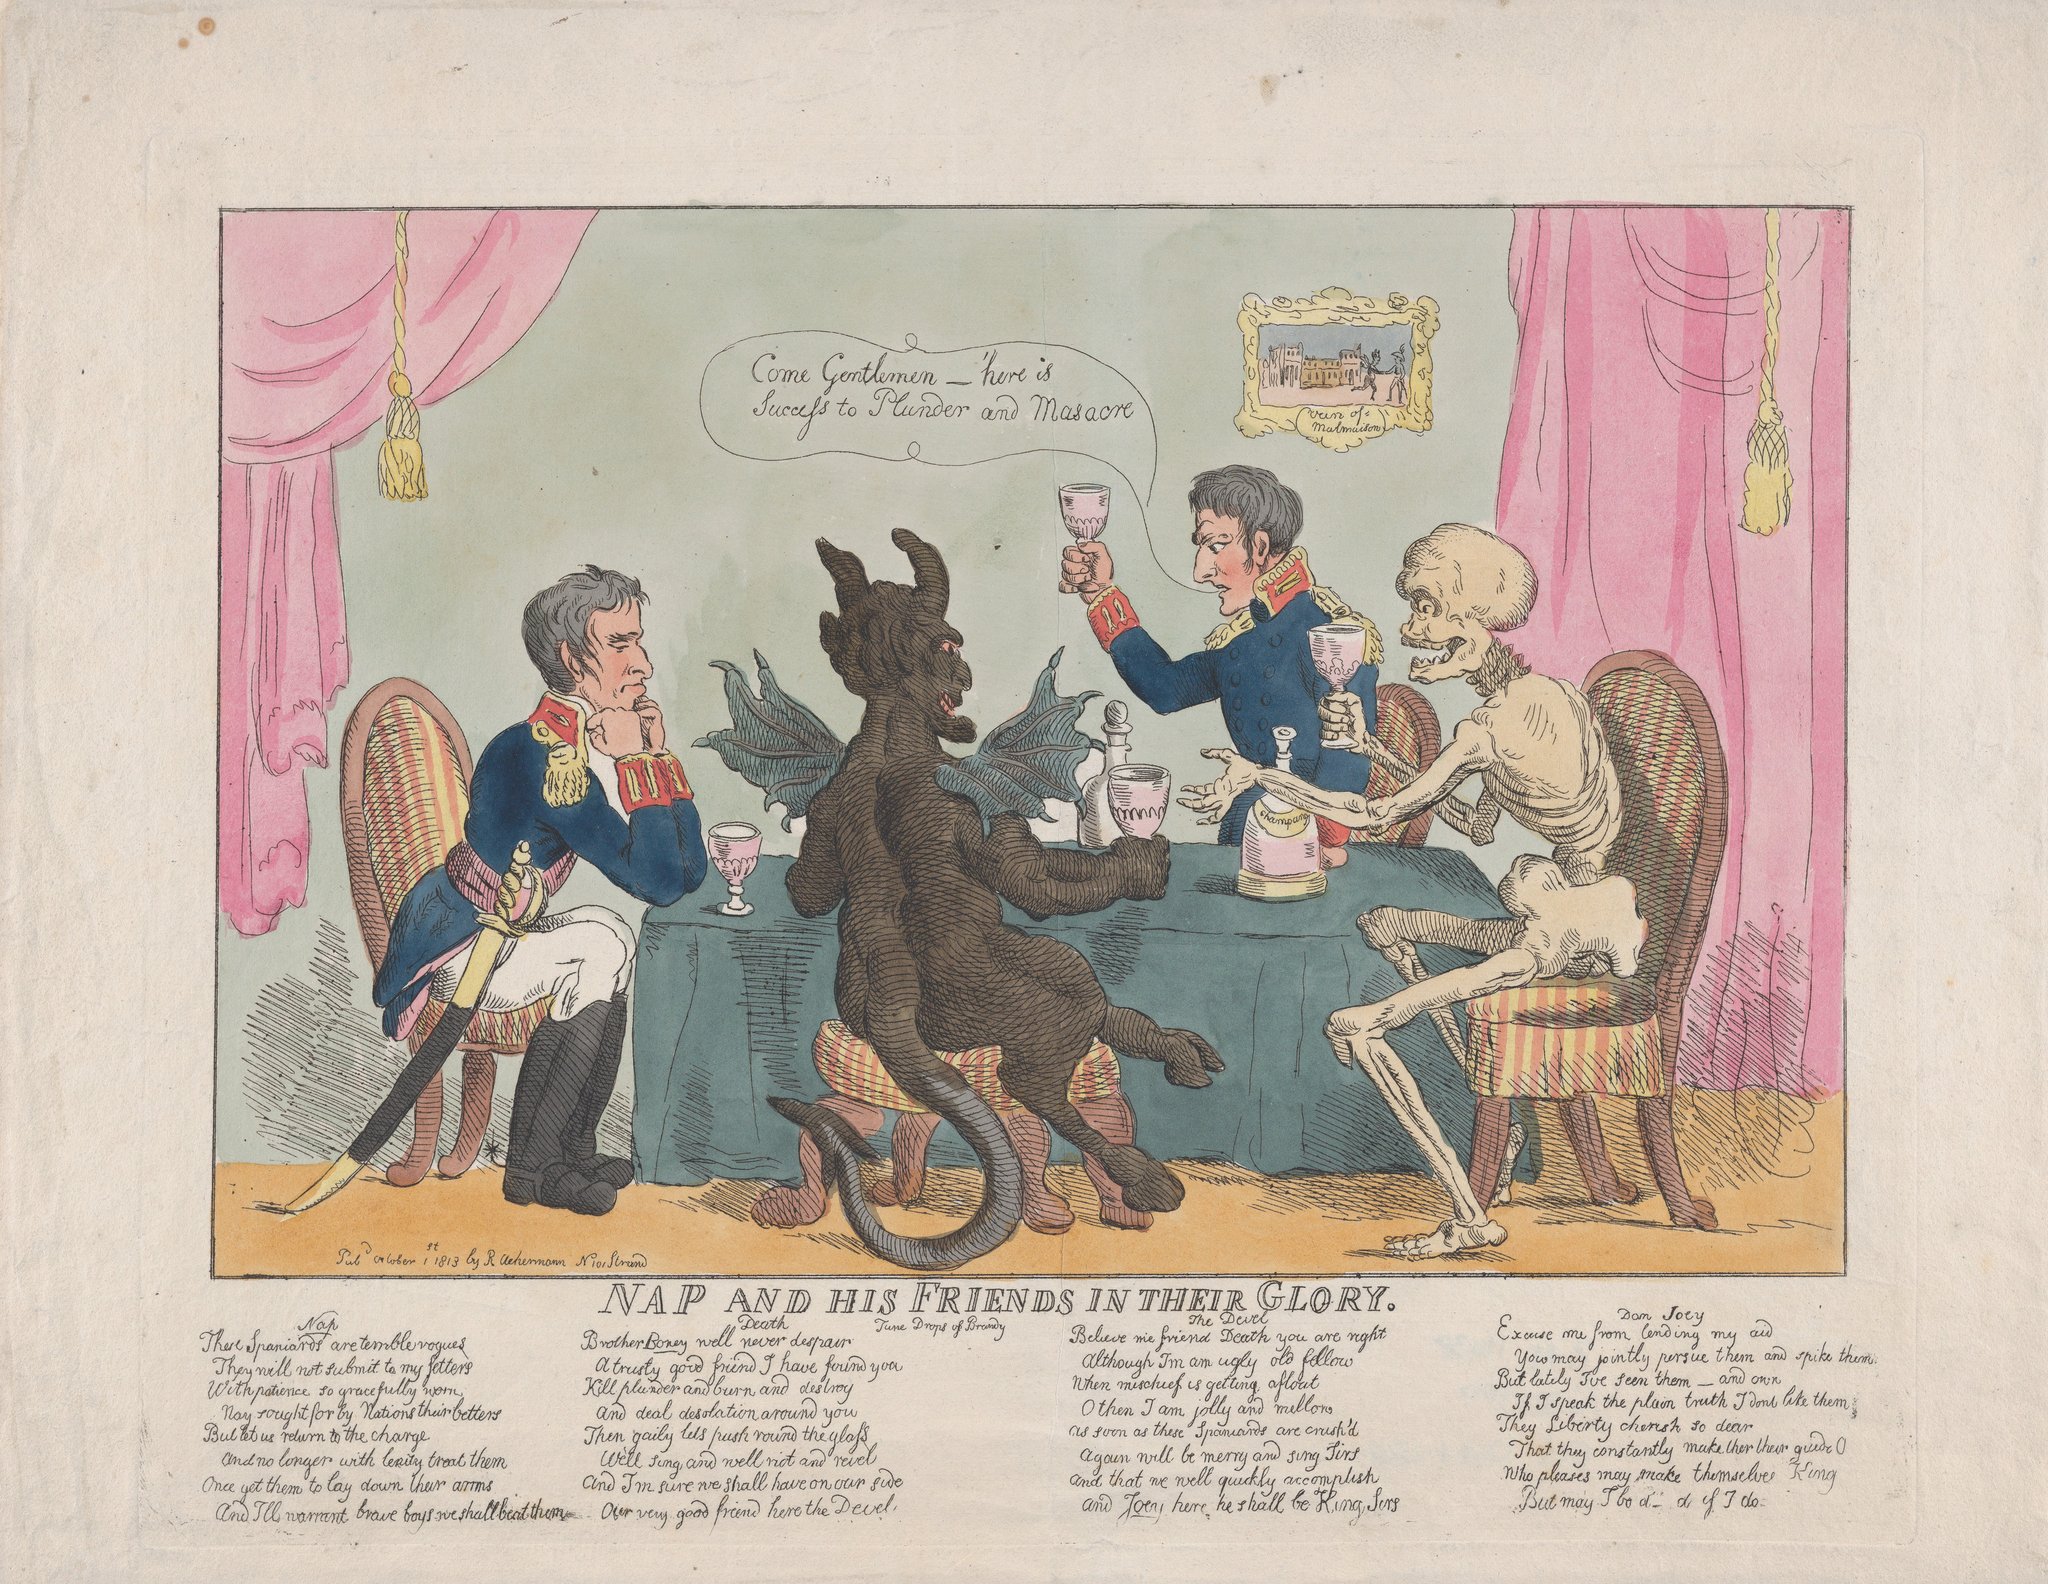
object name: print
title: Nap and His Friends in their Glory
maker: thomas rowlandson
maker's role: artist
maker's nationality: british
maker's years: 1757-1827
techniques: etching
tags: satire,napoleon i,skeletons,men,drinking,politics